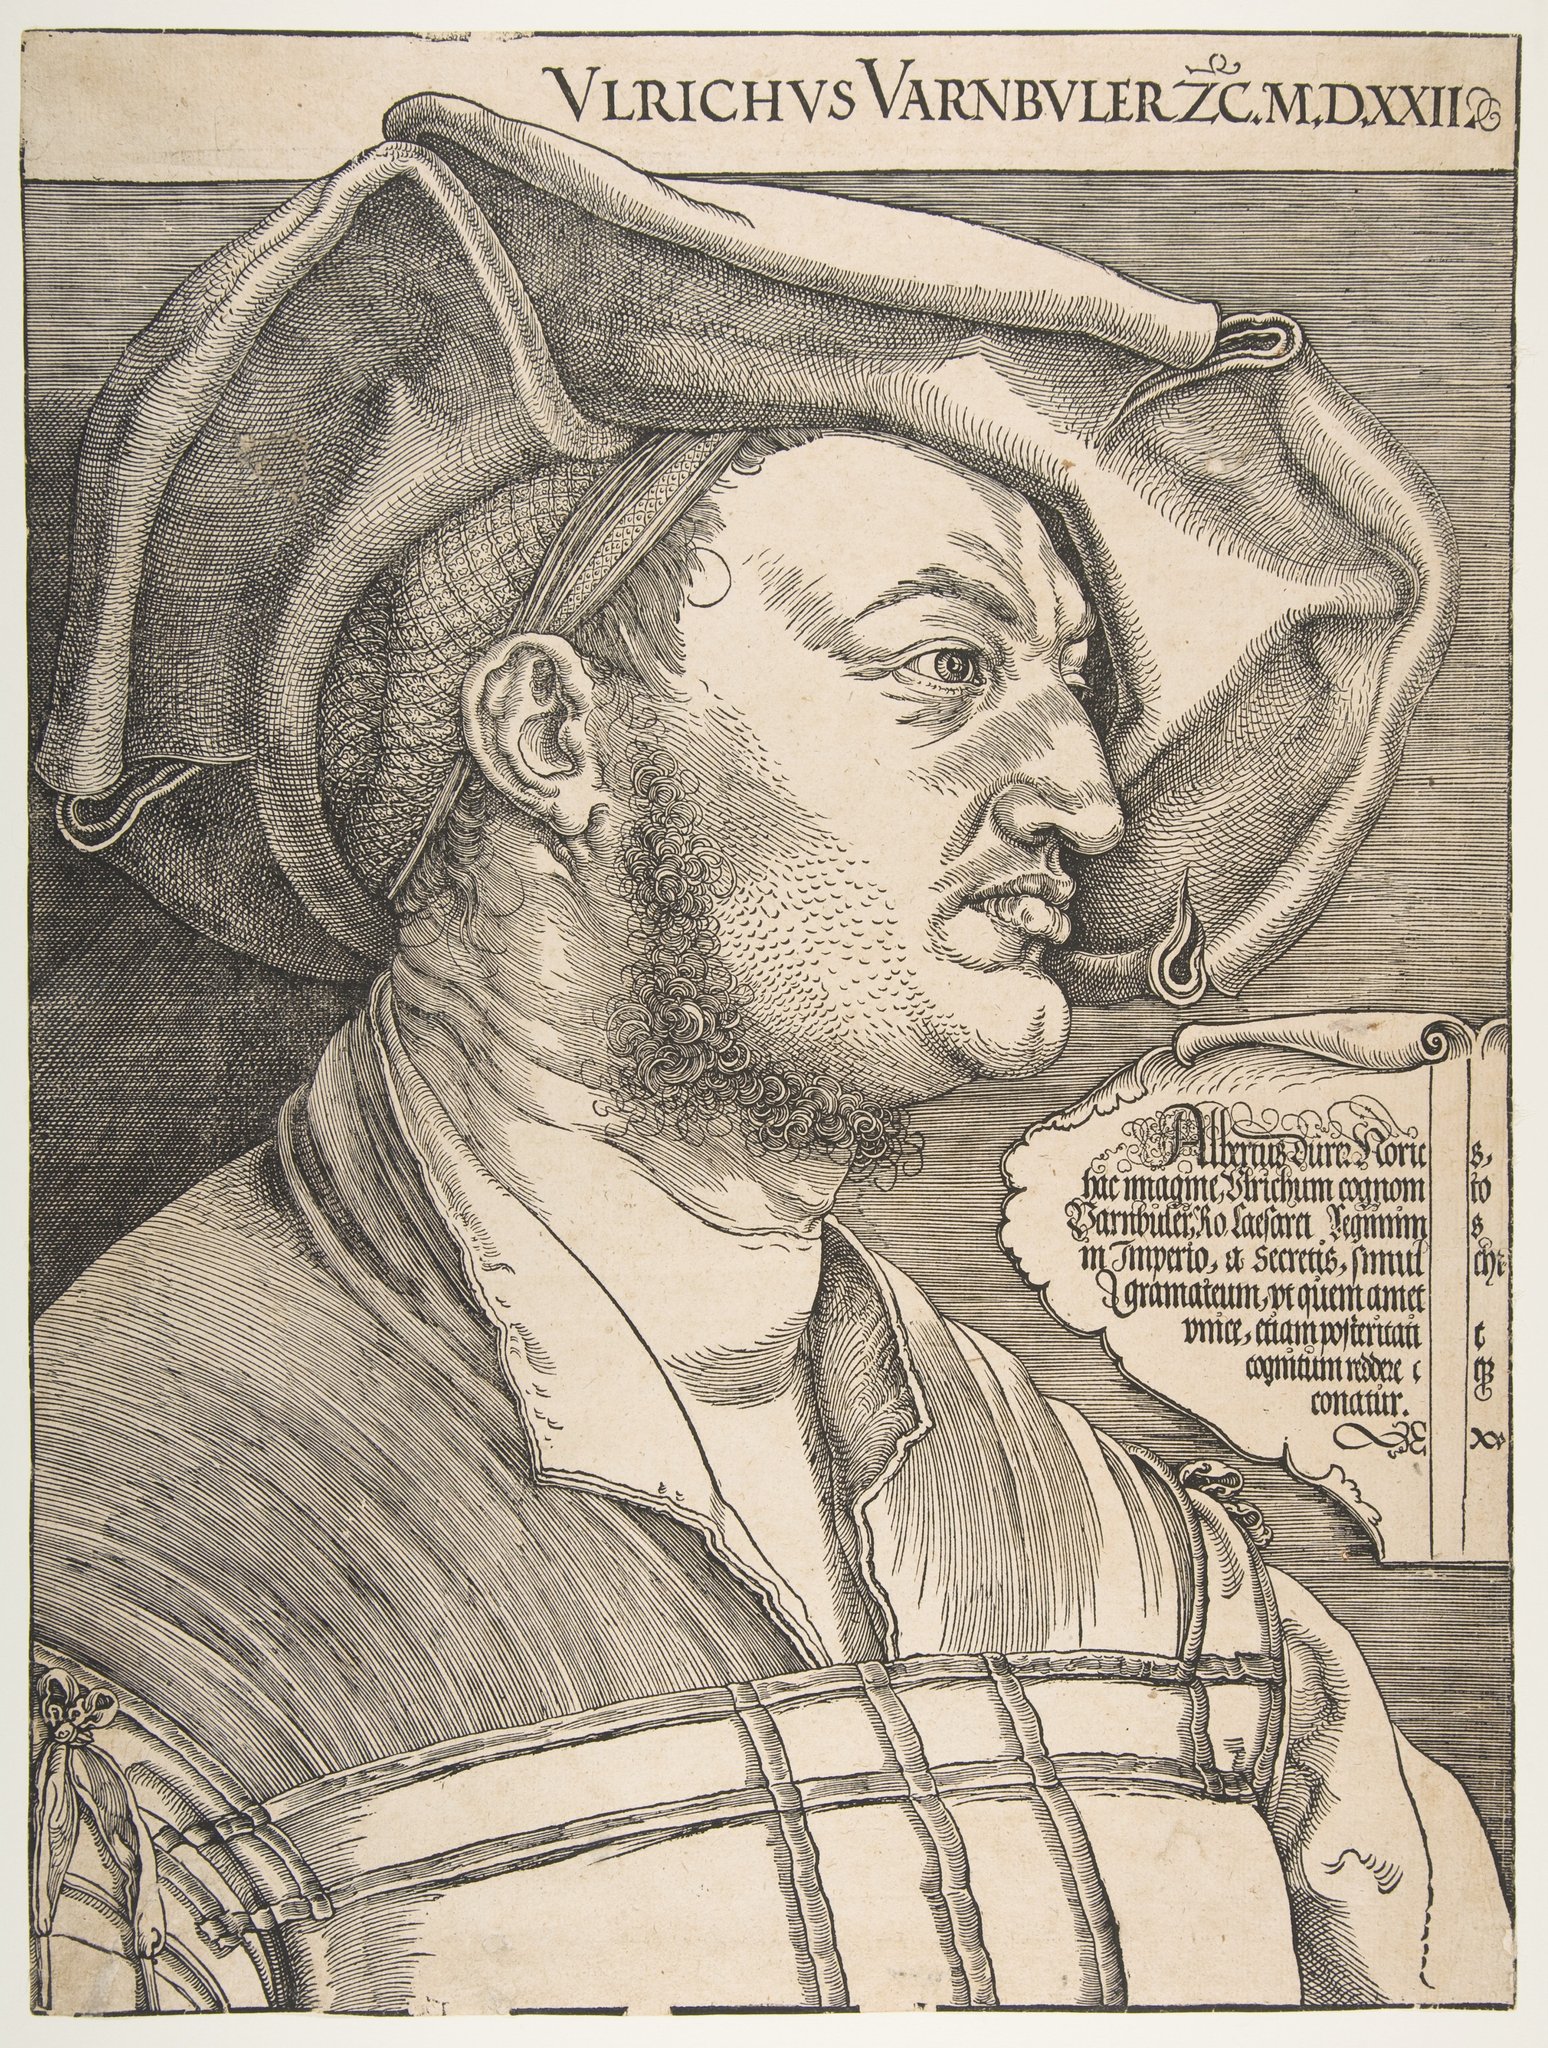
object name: print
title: Portrait of Ulrich Varnbuler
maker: albrecht dürer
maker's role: artist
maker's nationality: german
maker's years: 1471-1528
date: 1522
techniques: woodcut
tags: men,portraits